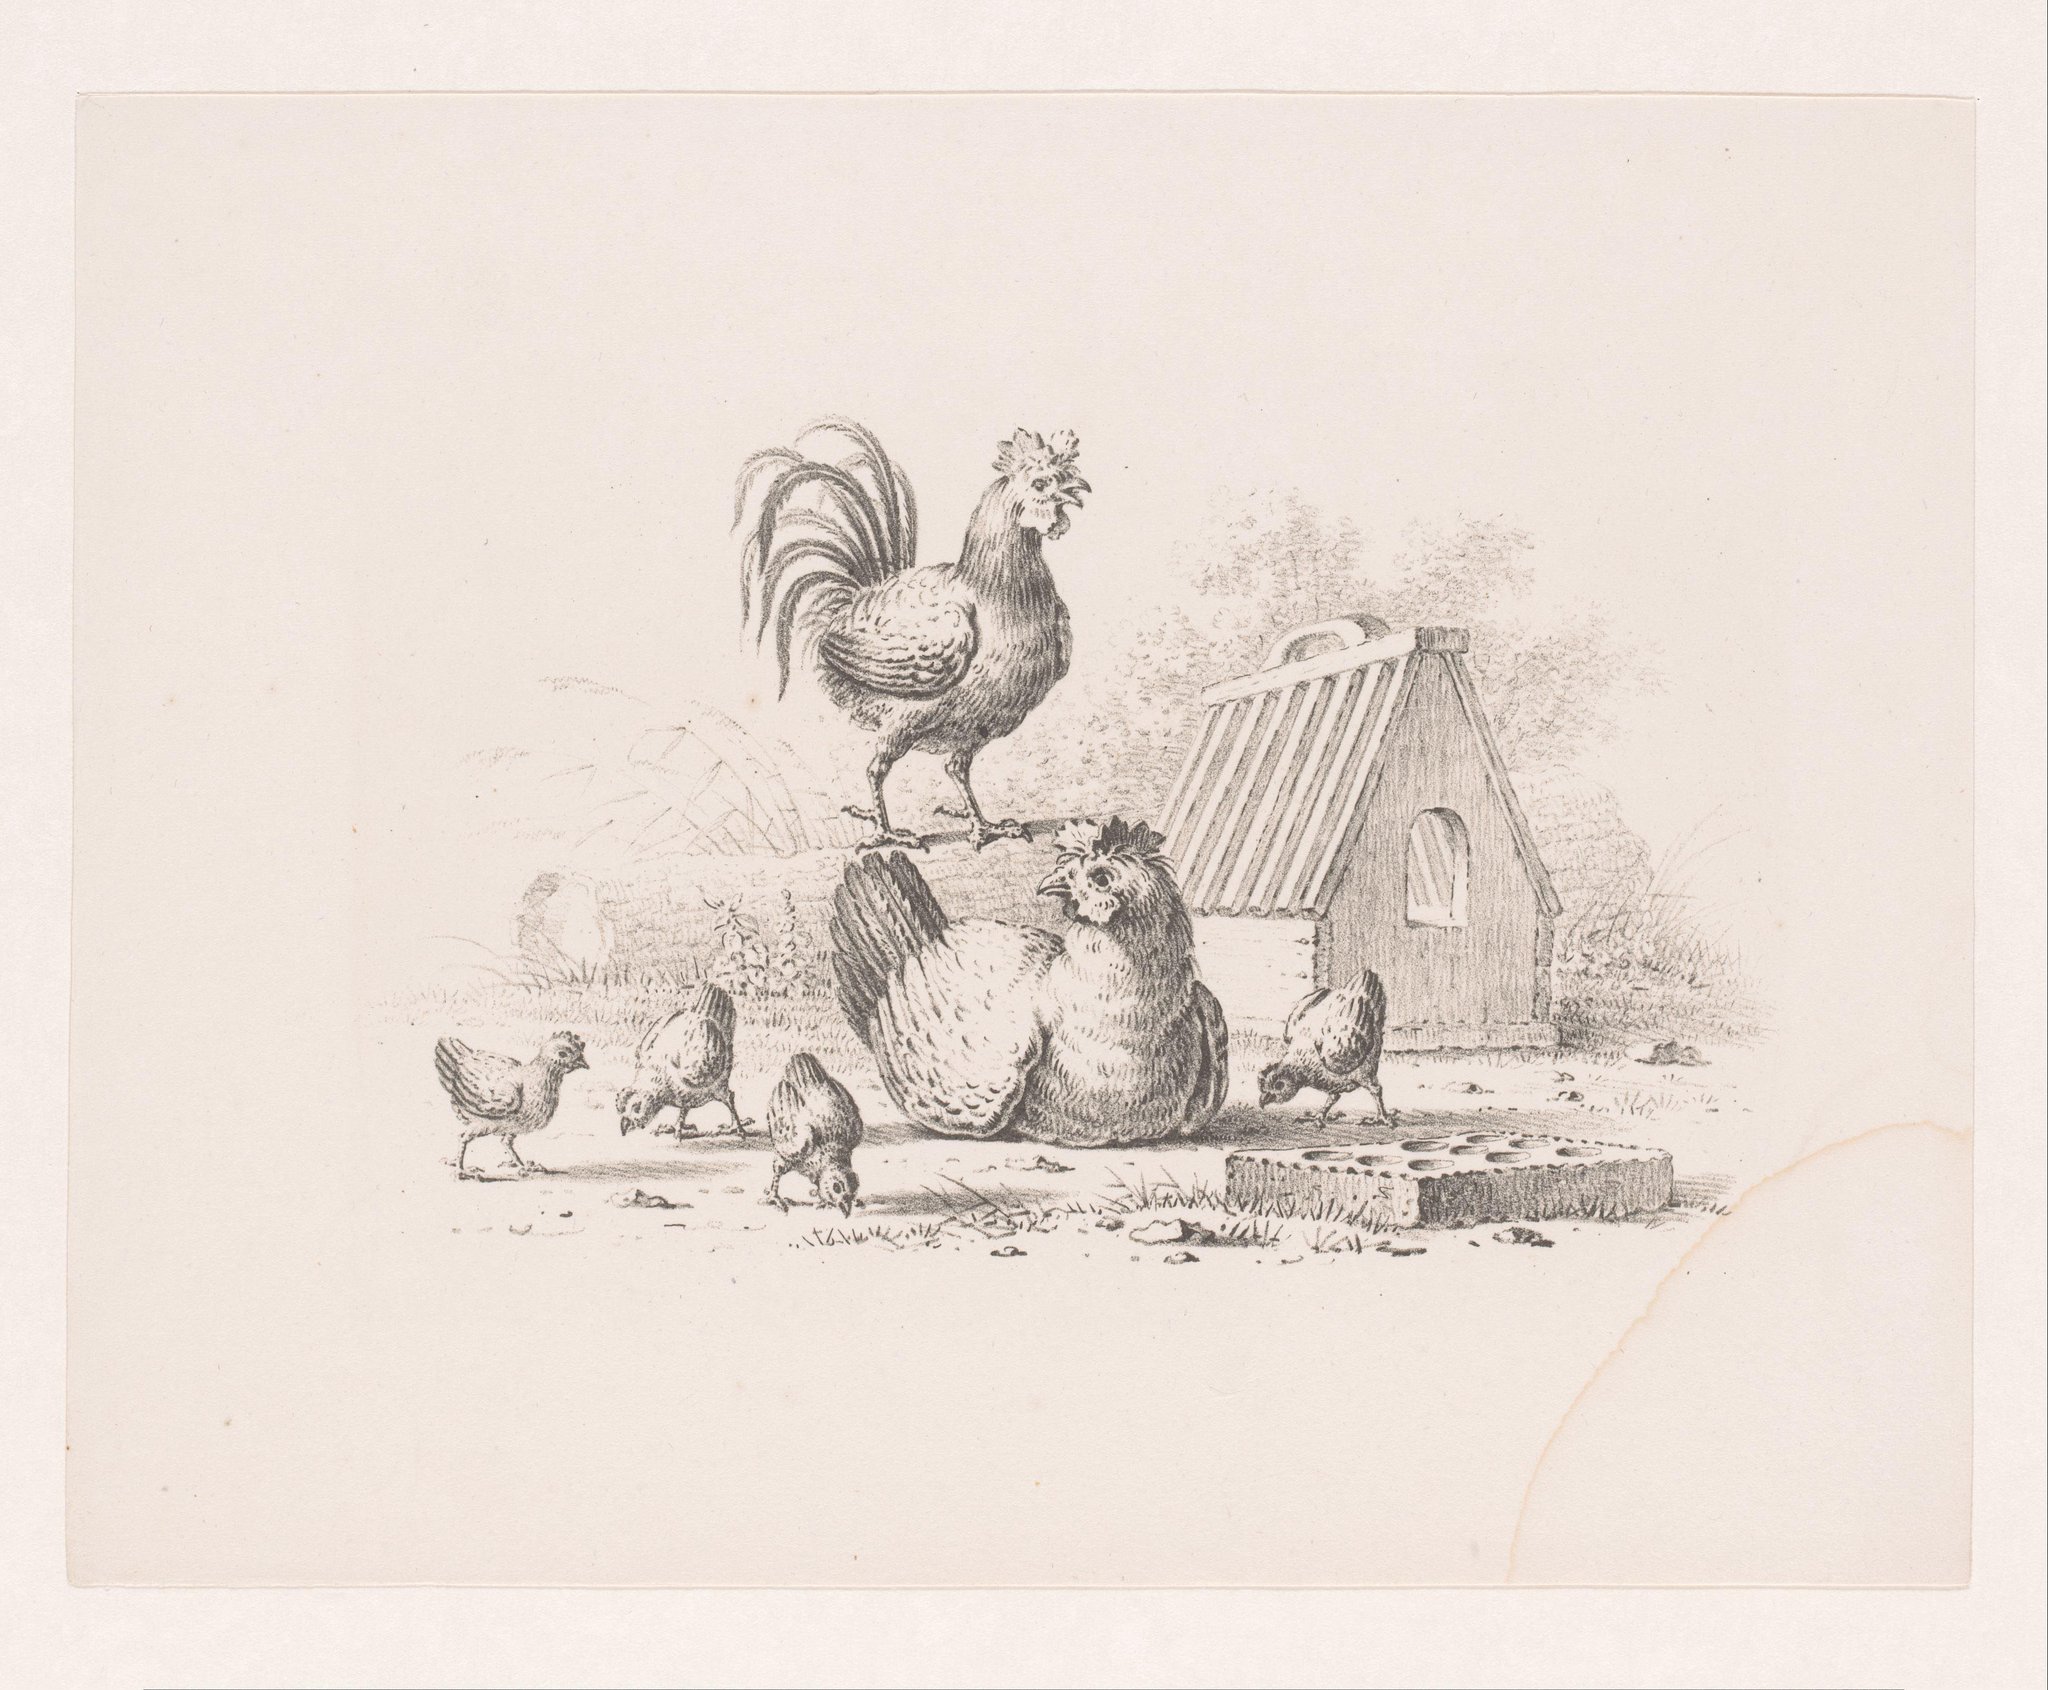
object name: print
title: Haan, kip en kuikens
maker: pieter de goeje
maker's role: draughtsman, print maker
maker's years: 1789-1859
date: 1809-1859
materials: paper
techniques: lithograph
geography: netherlands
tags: fowl (cock, hen, chicken, etc.), chicken house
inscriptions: collector's mark: Lugt 2228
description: De haan staat op een boomstronk naast een kippenhok.